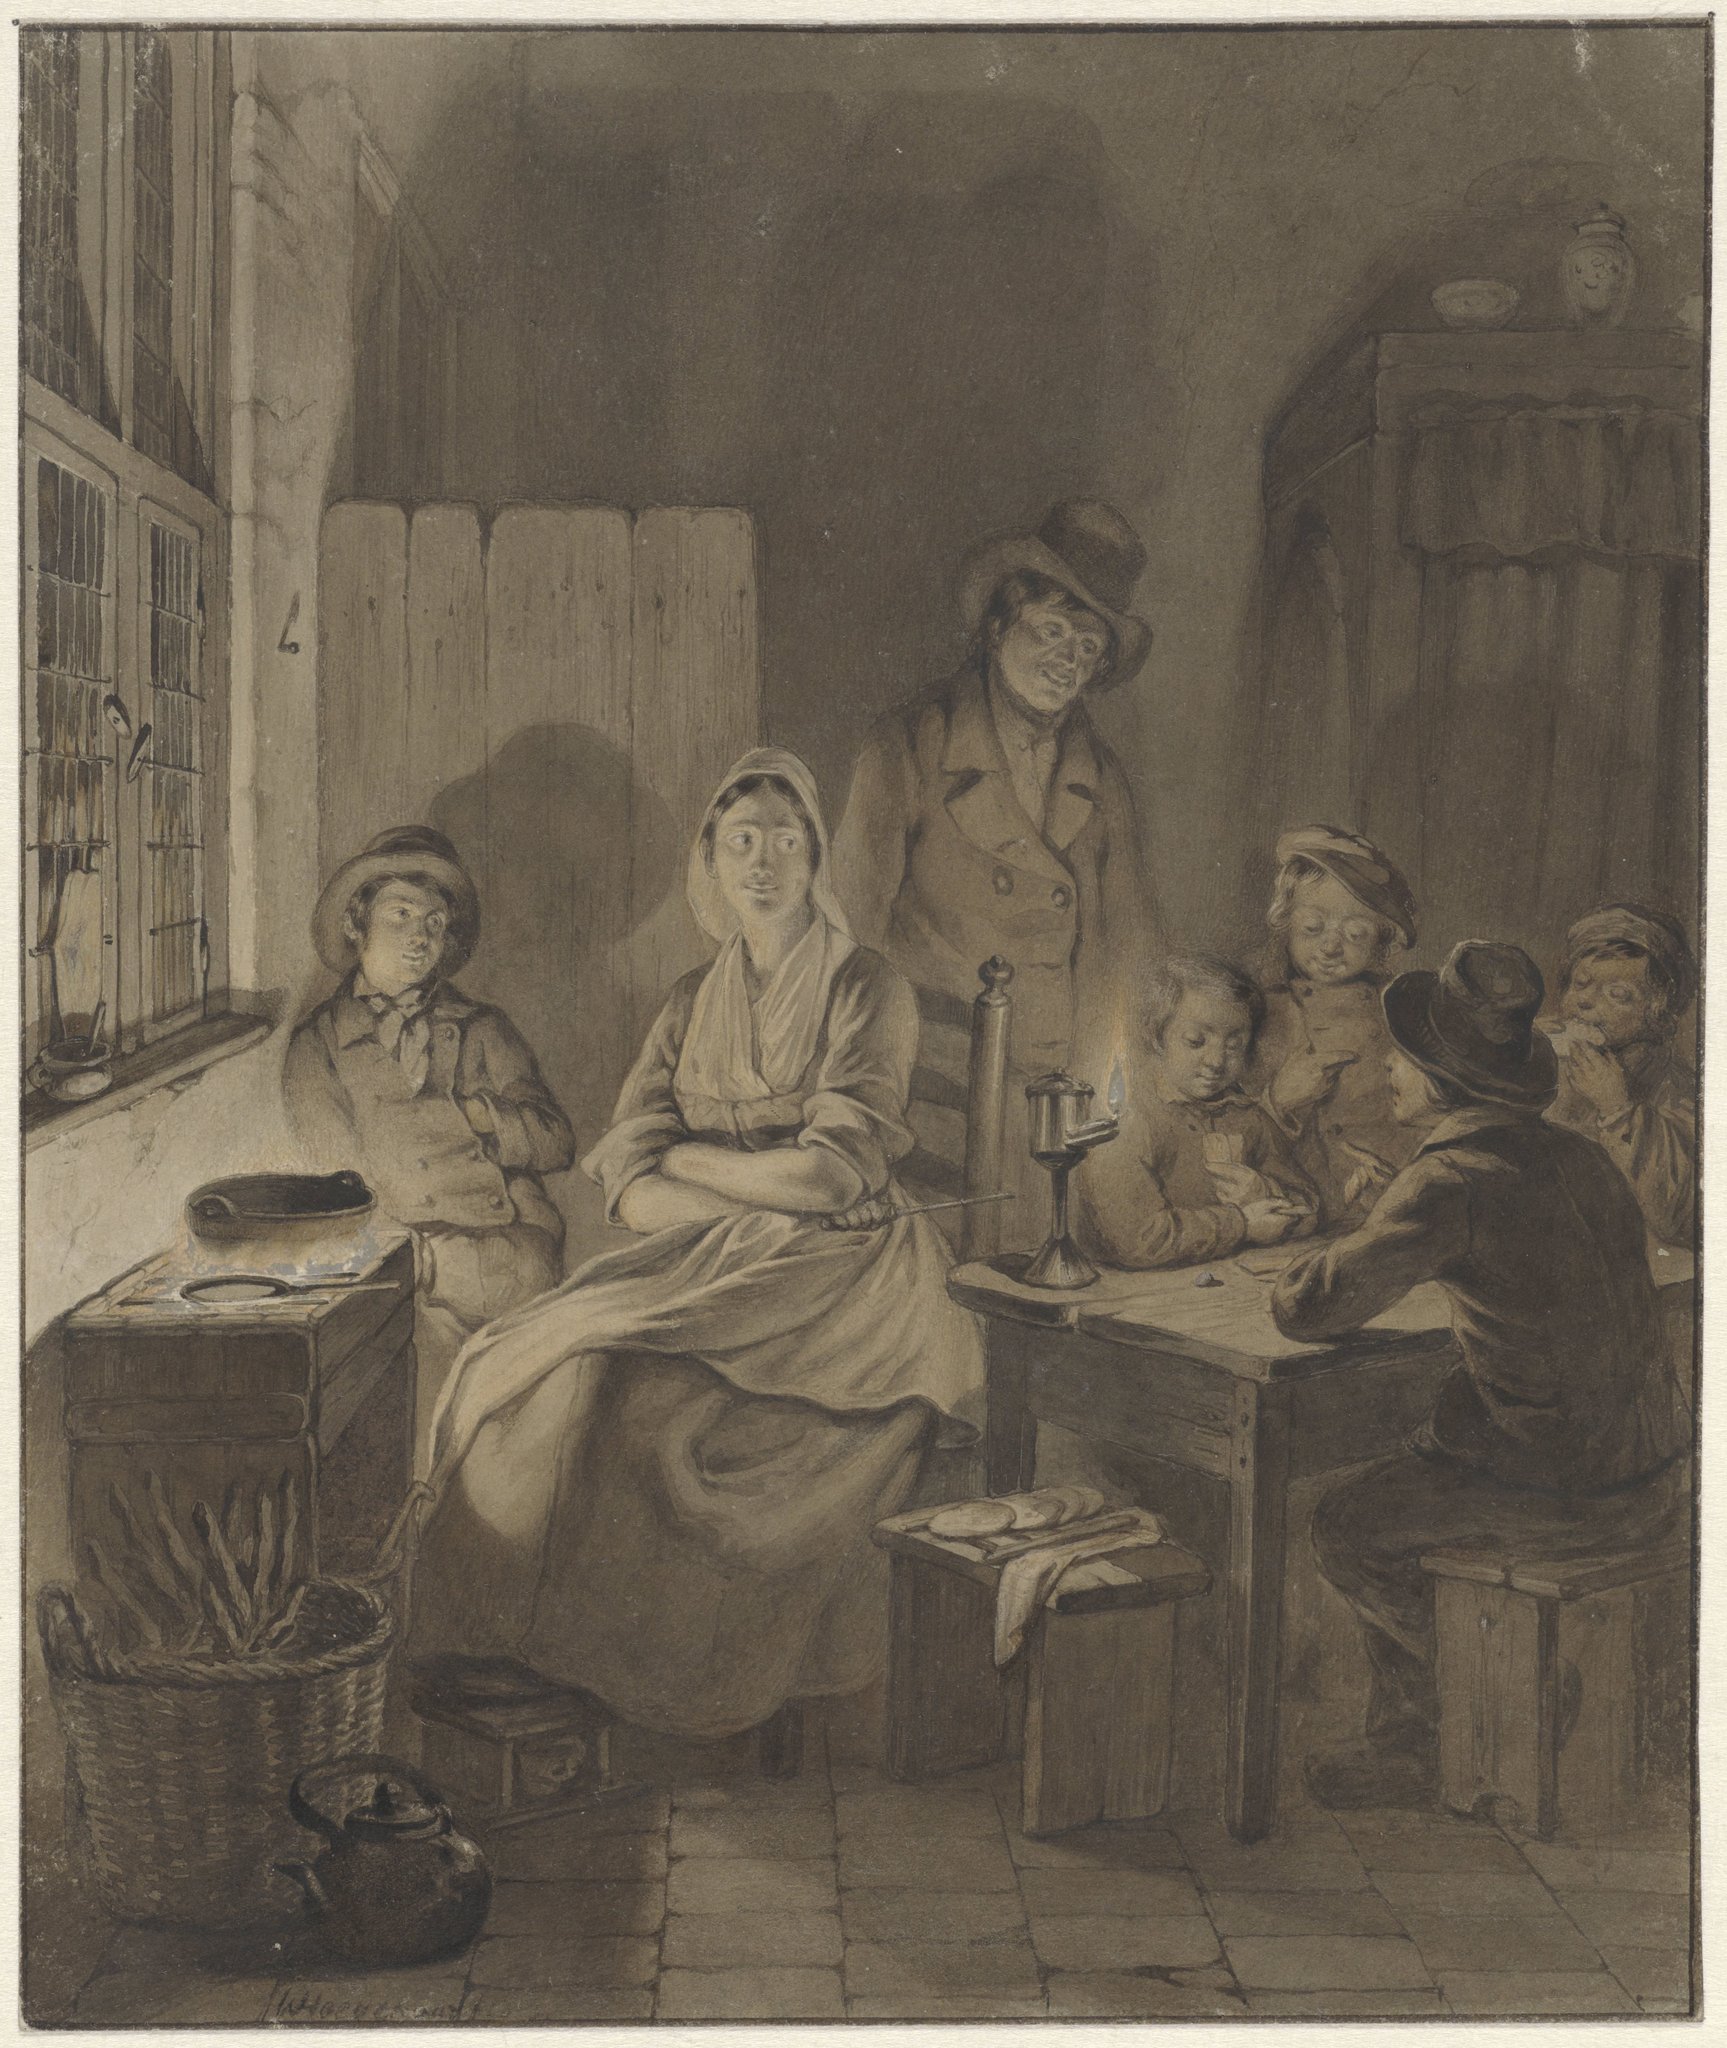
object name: drawing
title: Interieur met groep mensen rond tafel bij kaarslicht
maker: willem pieter hoevenaar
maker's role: draughtsman, painter, print maker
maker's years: 1808-1863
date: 1818-1863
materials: paint, ink, paper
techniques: brush, pen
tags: family group, especially parents with their child(ren), interior of the house